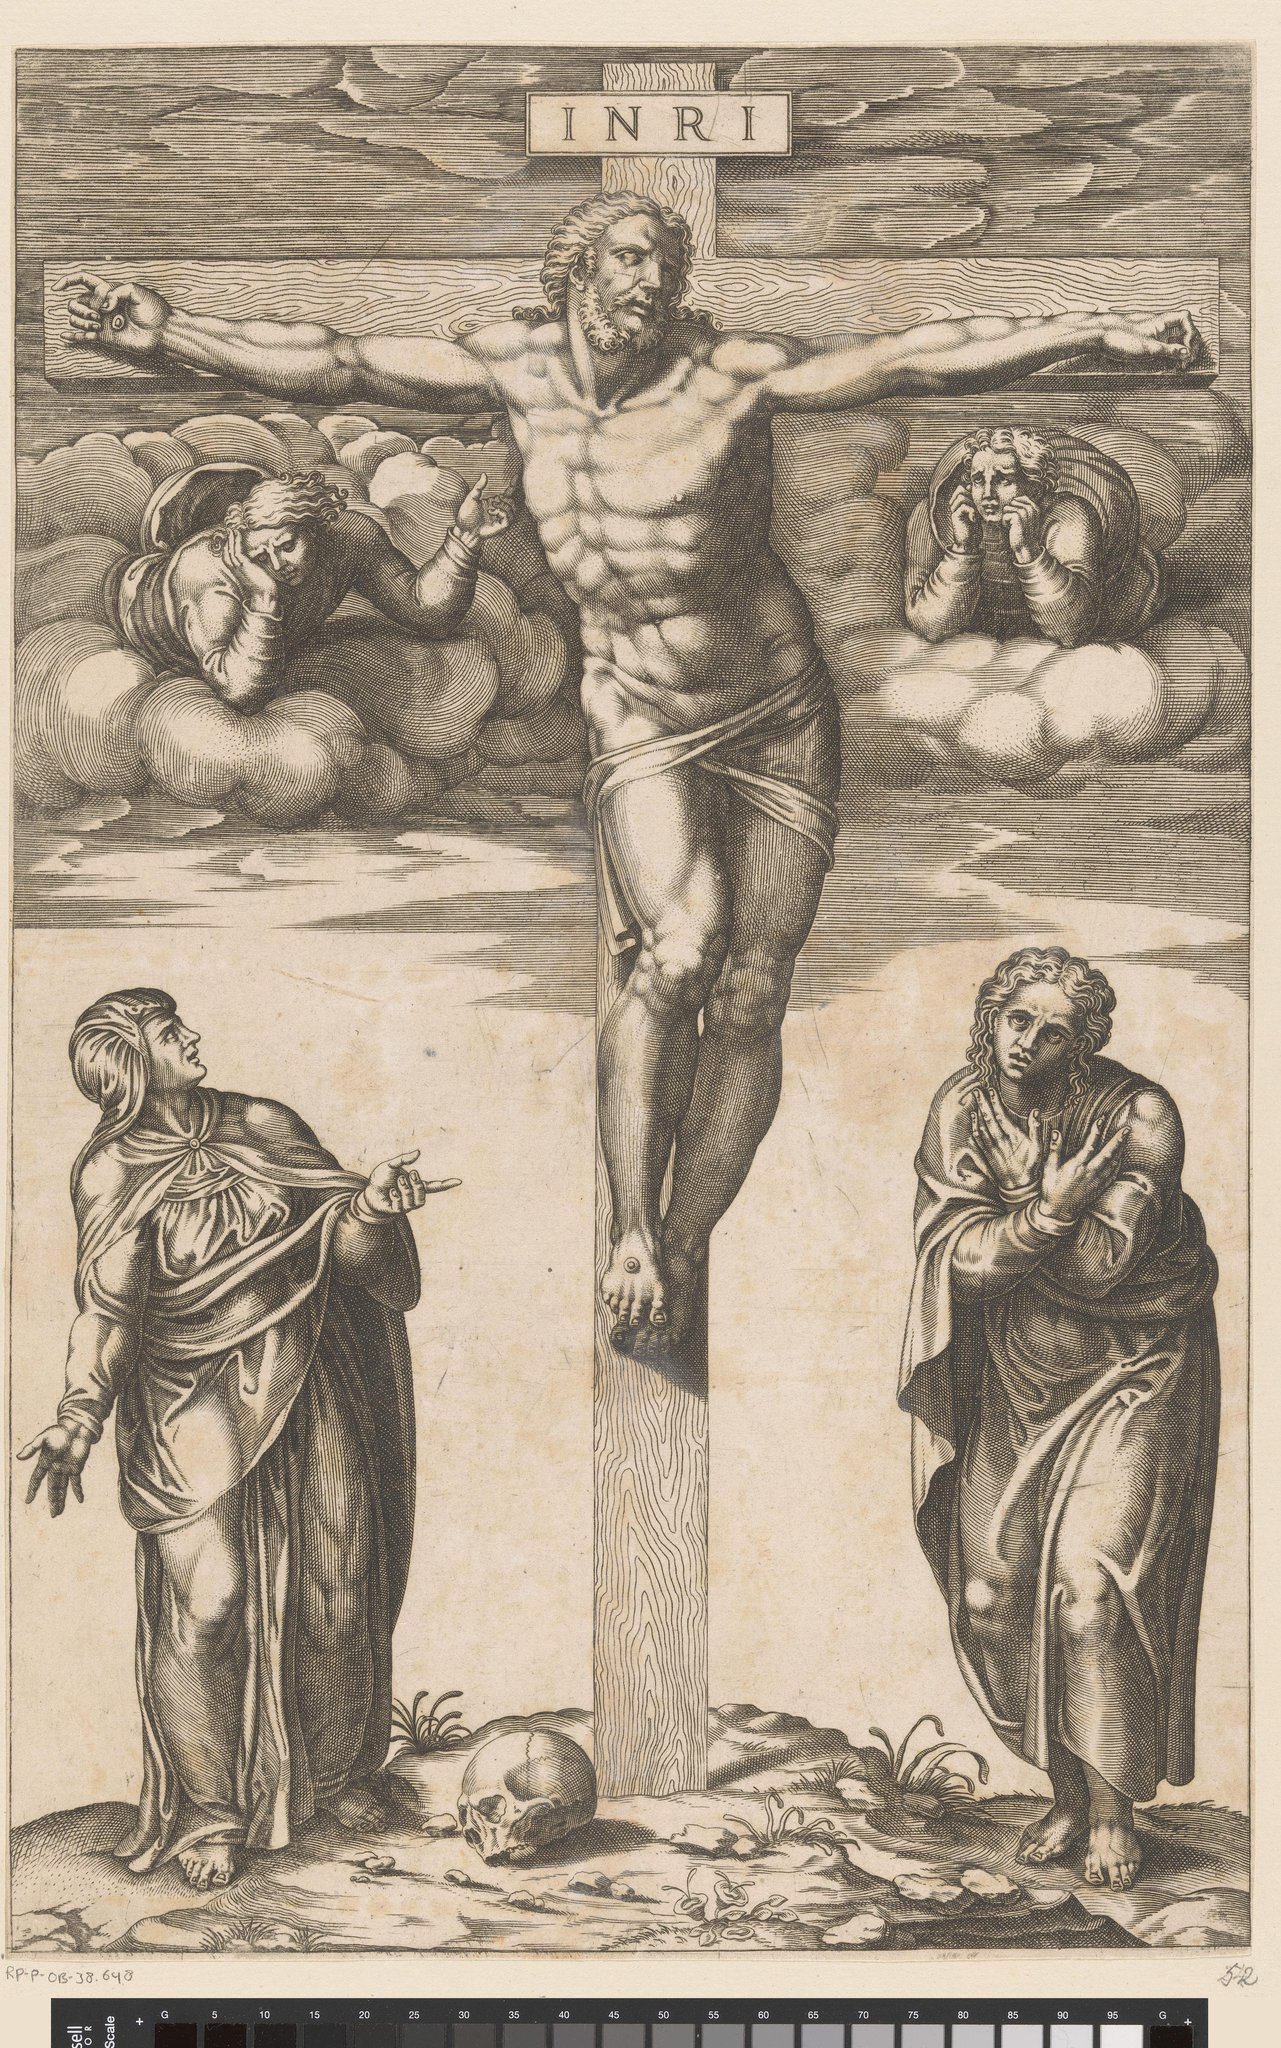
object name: print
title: Kruisiging van Christus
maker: Anonymous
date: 1485-1564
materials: paper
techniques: engraving, etching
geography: italy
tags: crucified christ with mary and john on either side of the cross; holy rood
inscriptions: collector's mark: Lugt 240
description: Landschap met Christus aan het kruis geflankeerd door Maria en Johannes. Op de wolken twee treurende engelen.